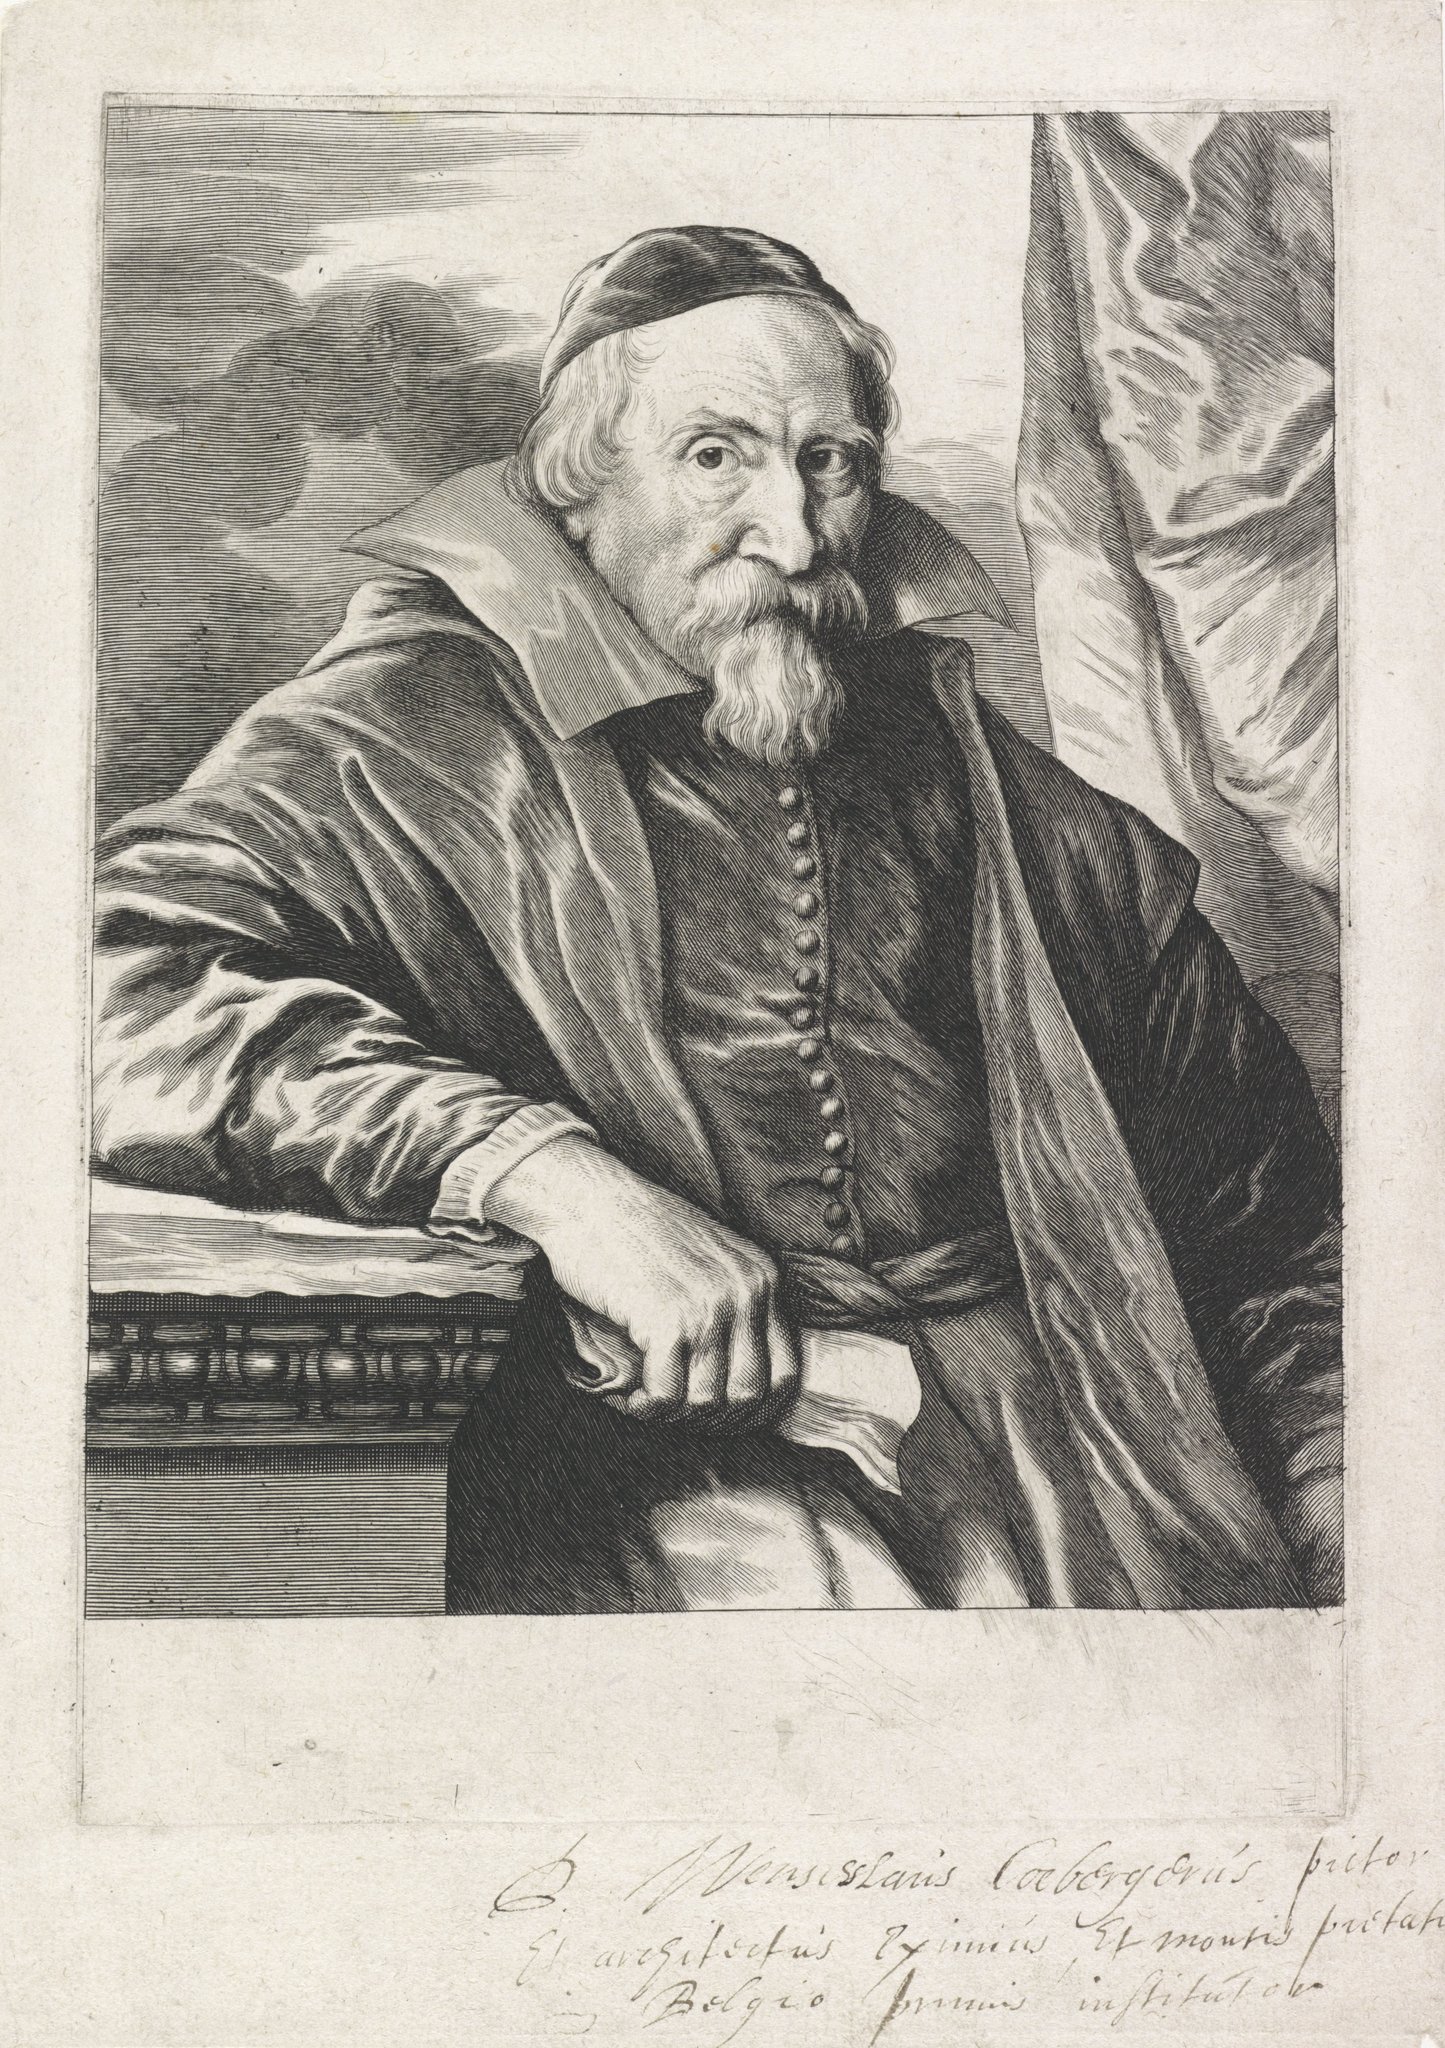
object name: print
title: Iconographie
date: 1630-1646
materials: paper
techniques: engraving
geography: antwerp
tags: antwerp, brussels, painter, draughtsman, wenzel coebergher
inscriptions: collector's mark: Lugt 240, inscription: ‘Wensislaus Coebergus pictor [...] Belgio primus inflitator’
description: Prent gebruikt voor: Icones principum, virorum doctorum, pictorum, chalcographorum, statuariorum nec non amatorum pictoriae artis numero centum ab Ant. van Dyck ad vivum expressae ejusque sumptibus aeri incisae. Antwerpen: Gillis Hendricx, [1645-1646].